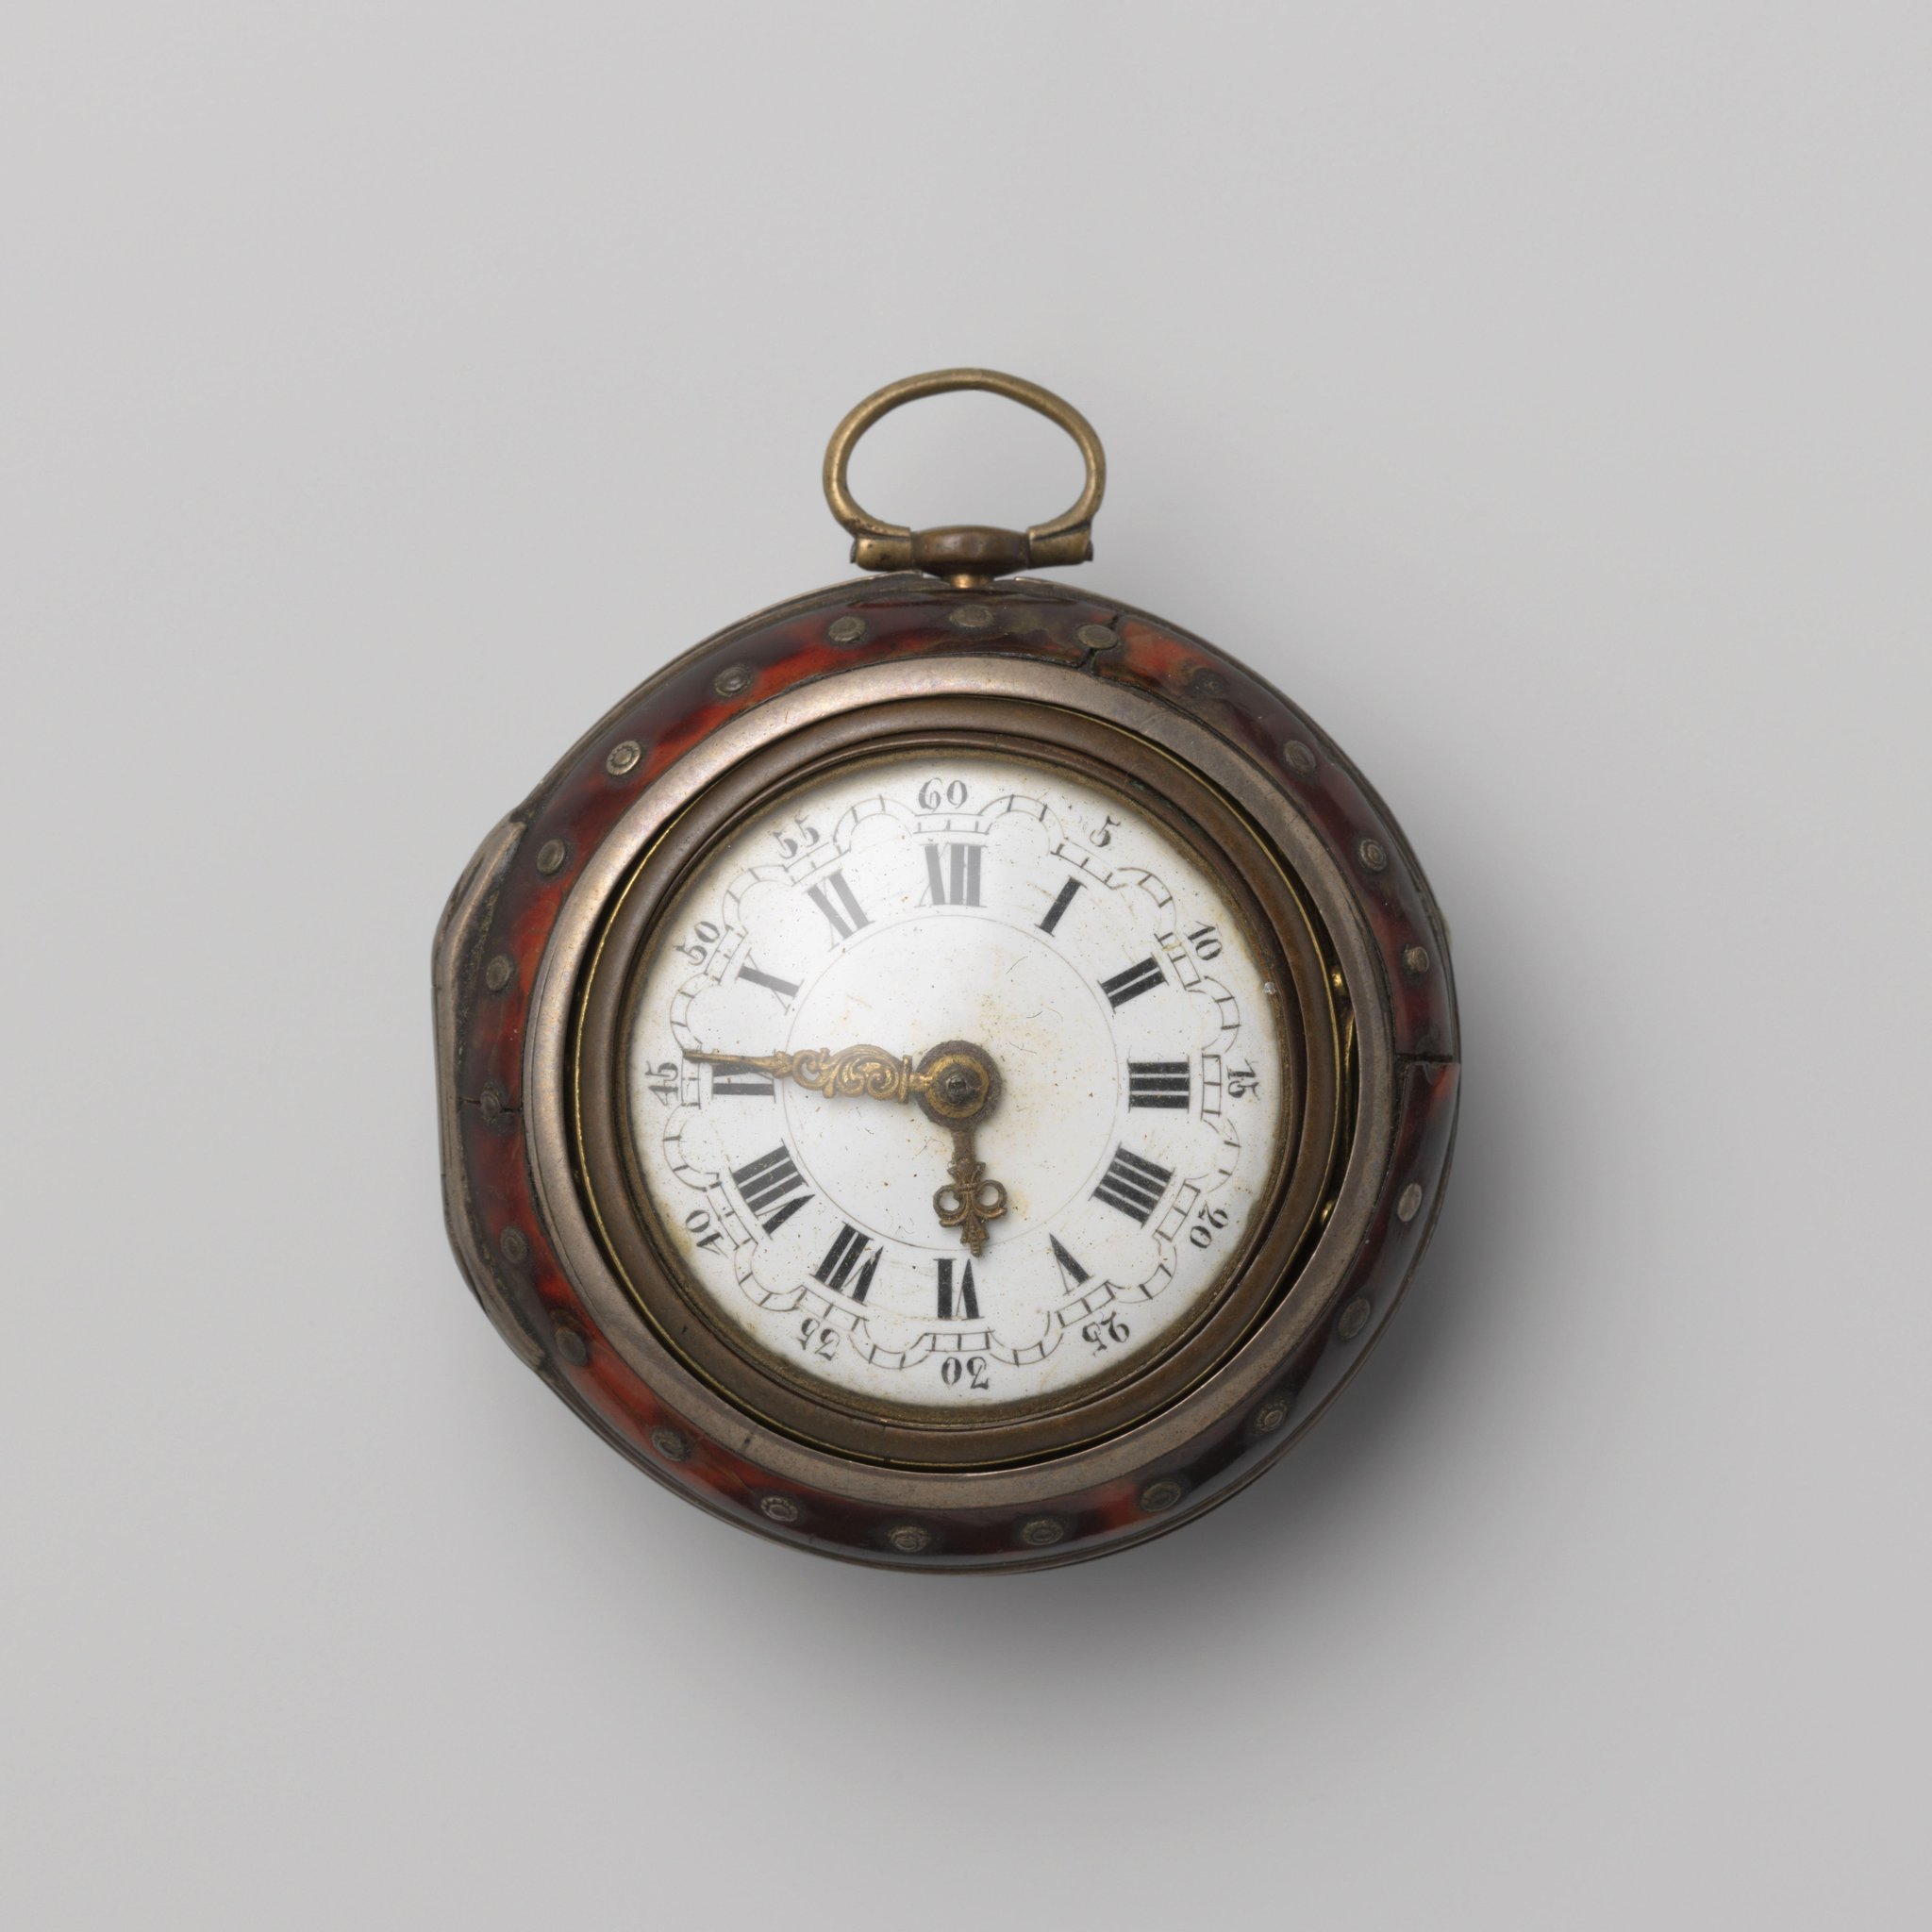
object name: jewellery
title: Zakhorloge met gedreven klassieke voorstelling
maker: john drills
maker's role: clockmaker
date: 1750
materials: copper, shell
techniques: gilding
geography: london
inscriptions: signature: ‘John Drills, London 5360’, retailer's mark: ‘Rudolf Bossert, Hoorn’, retailer's mark: ‘Van den Hartog’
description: Verguld koperen horloge in gedreven kast, en een tweede kast van schildpad. De wit geëmailleerde wijzerplaat heeft Romeinse uurcijfers en Arabische minuutcijfers. De platine met opengewerkte kloof met rankenornament is gesigneerd: John Drills, London 5360. Op de losse koperen kast een gedreven klassieke voorstelling. In de schildpadkast twee losse kastbodempapieren van Rudolf Bossert te Hoorn en Van den Hartog te Purmerend.